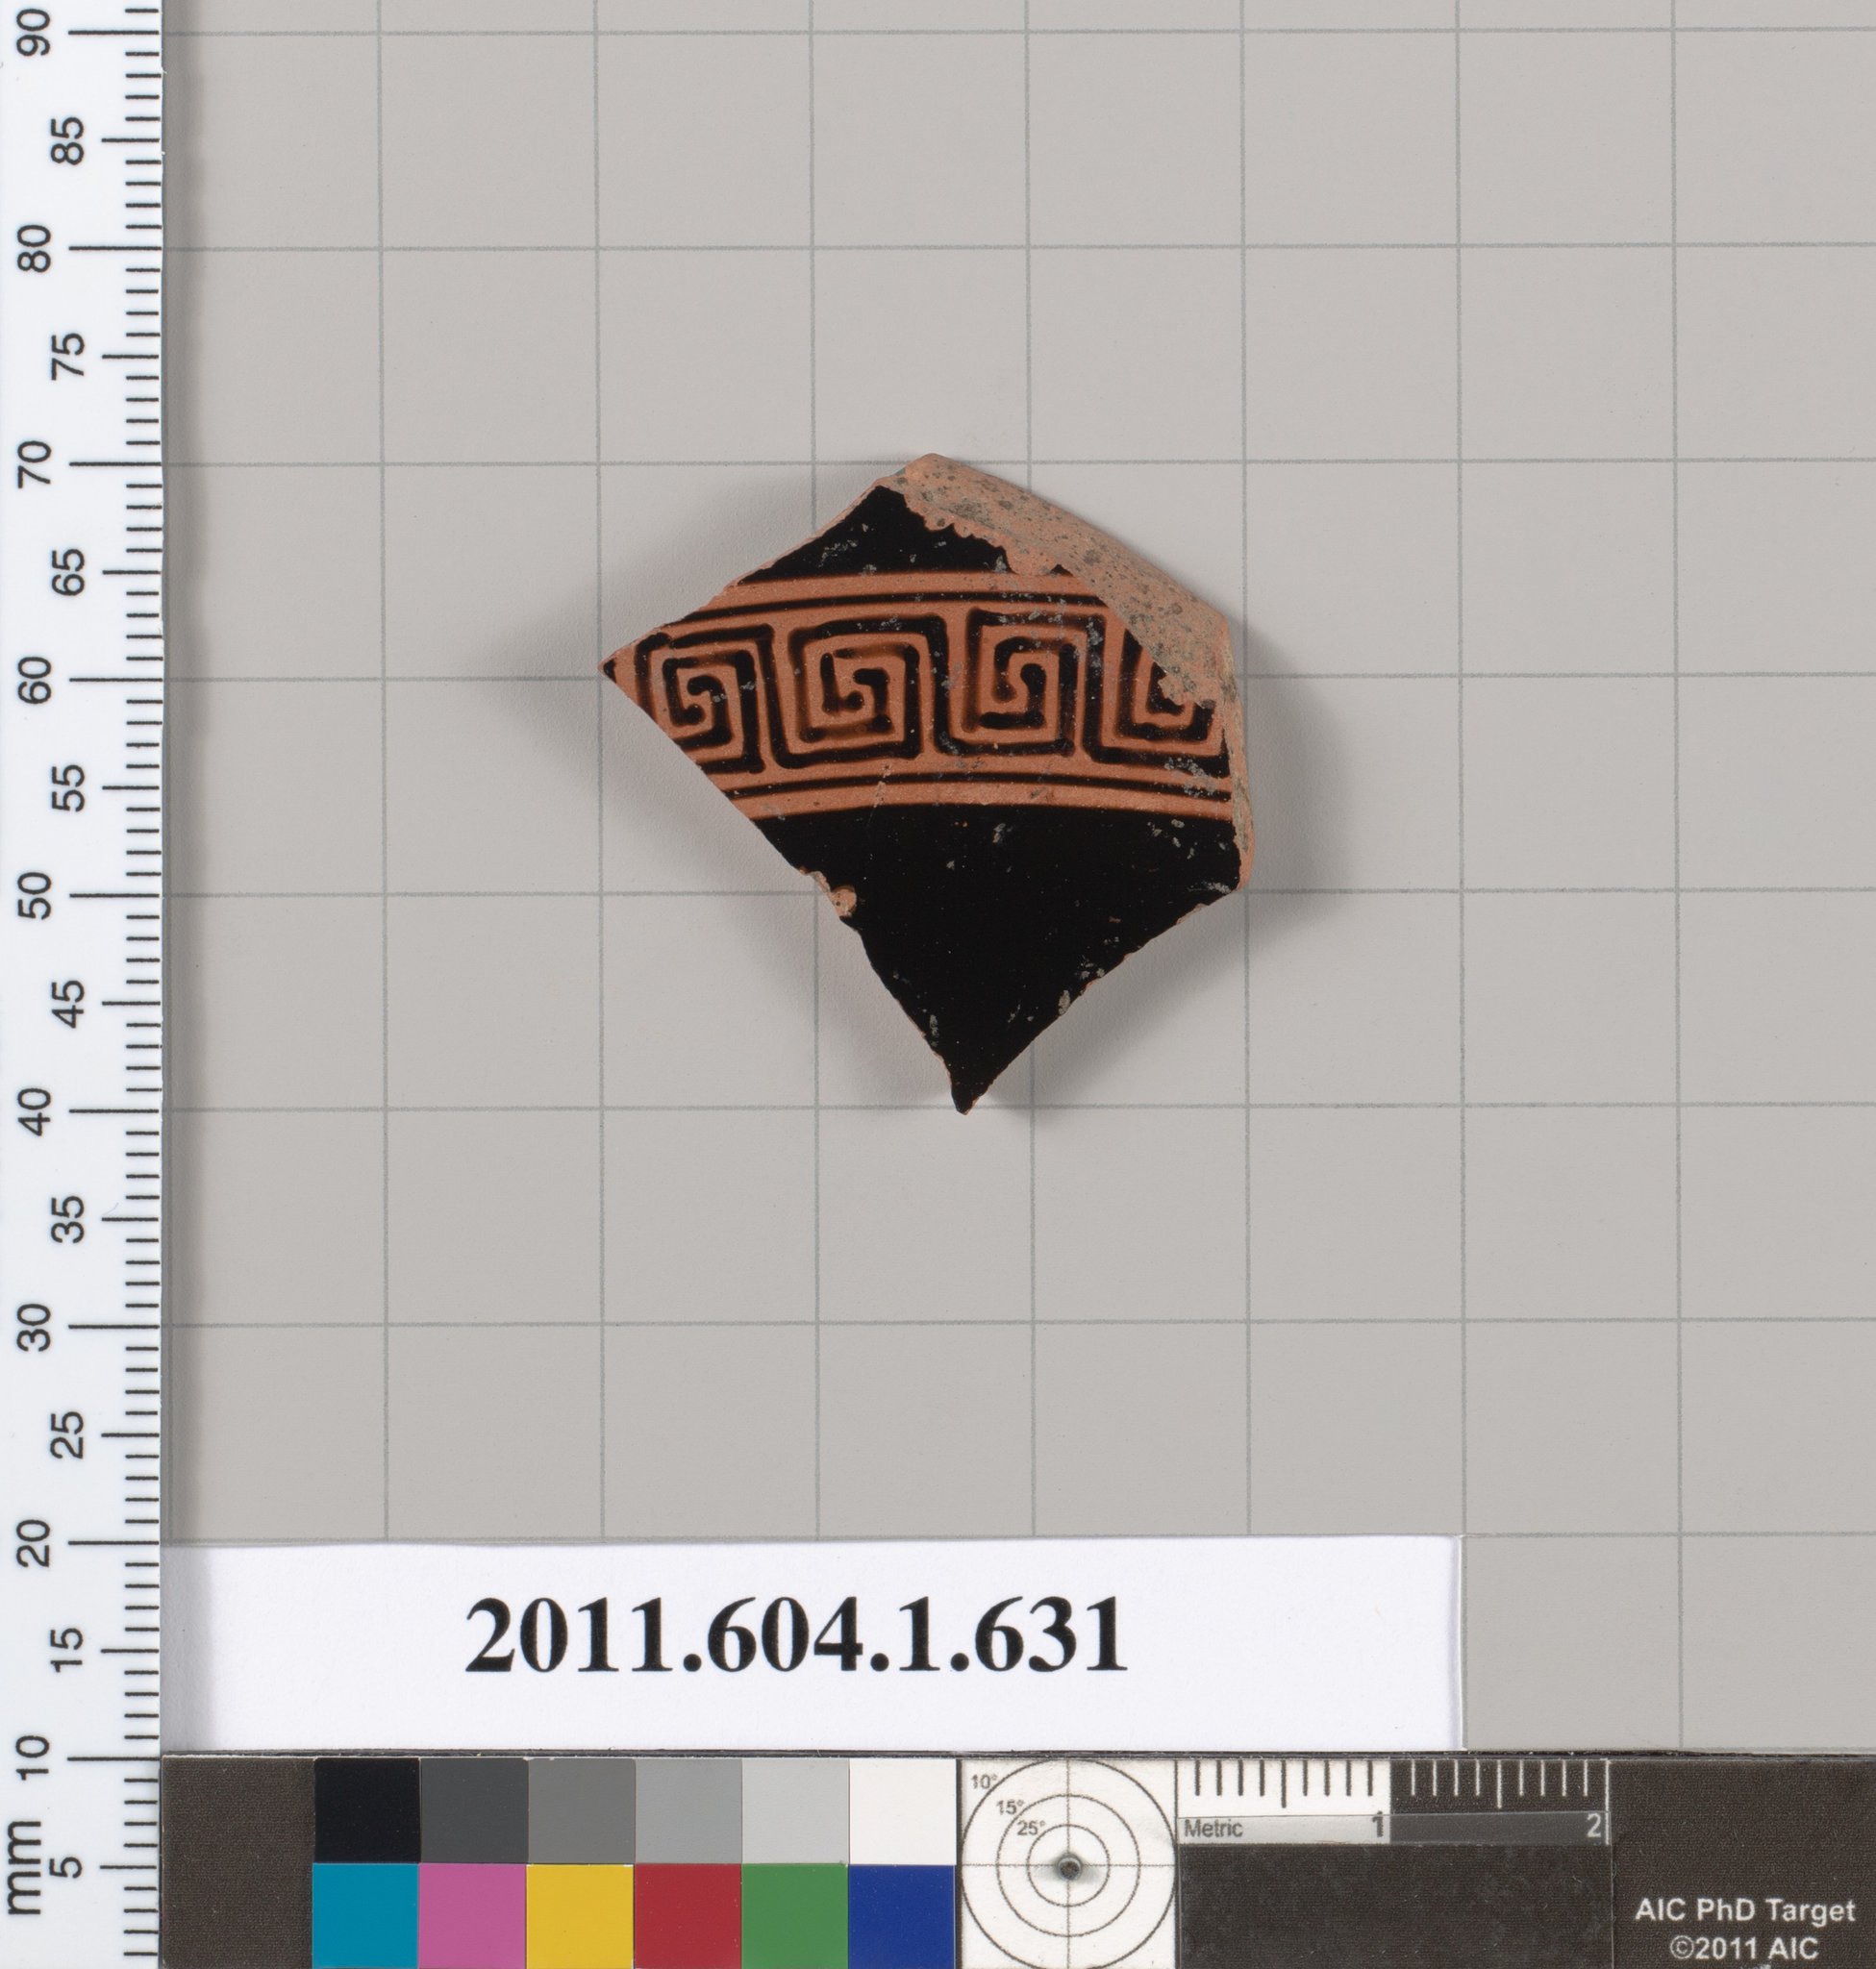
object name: kylix fragment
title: Terracotta fragment of a kylix (drinking cup)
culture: greek, attic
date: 475-451 BCE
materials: terracotta